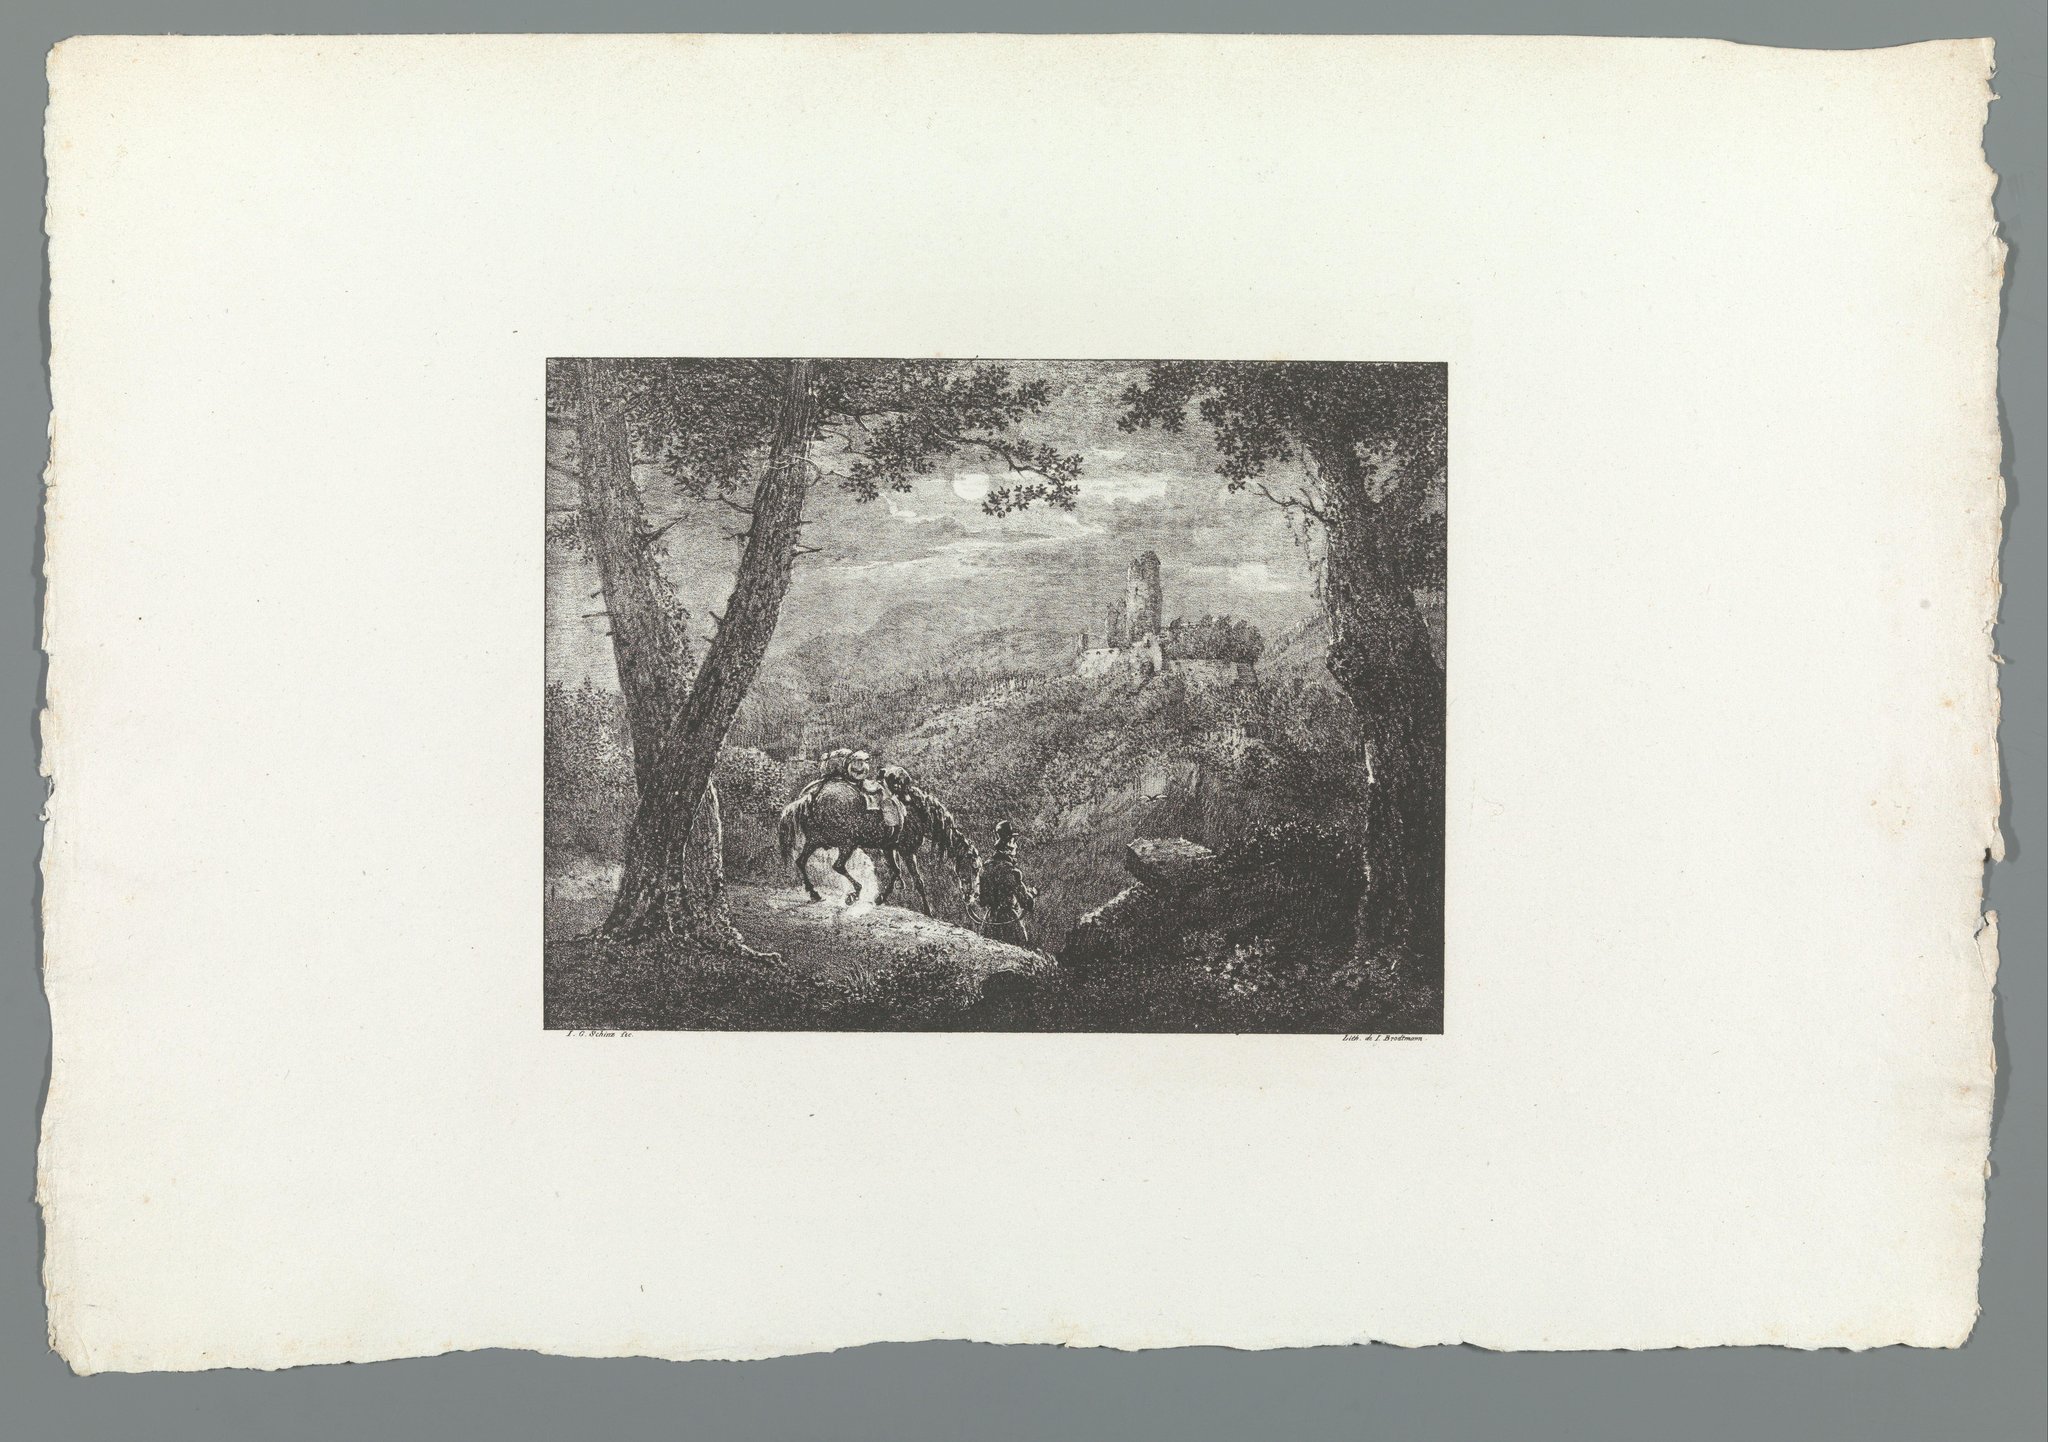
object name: print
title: Een ruiter lopend voor een vermoeid paard in de bergen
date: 1822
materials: paper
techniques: lithograph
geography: zurich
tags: riding a horse, ass, or mule; rider, horseman, mountains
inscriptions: collector's mark: Lugt 2760, collector's mark: ‘RA WANKLER’, collector's mark: Lugt 2228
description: Krijtlitho afkomstig uit de 'Lithographische Original-Zeichnungen von J.G. Schinz, Zürich 1822'.